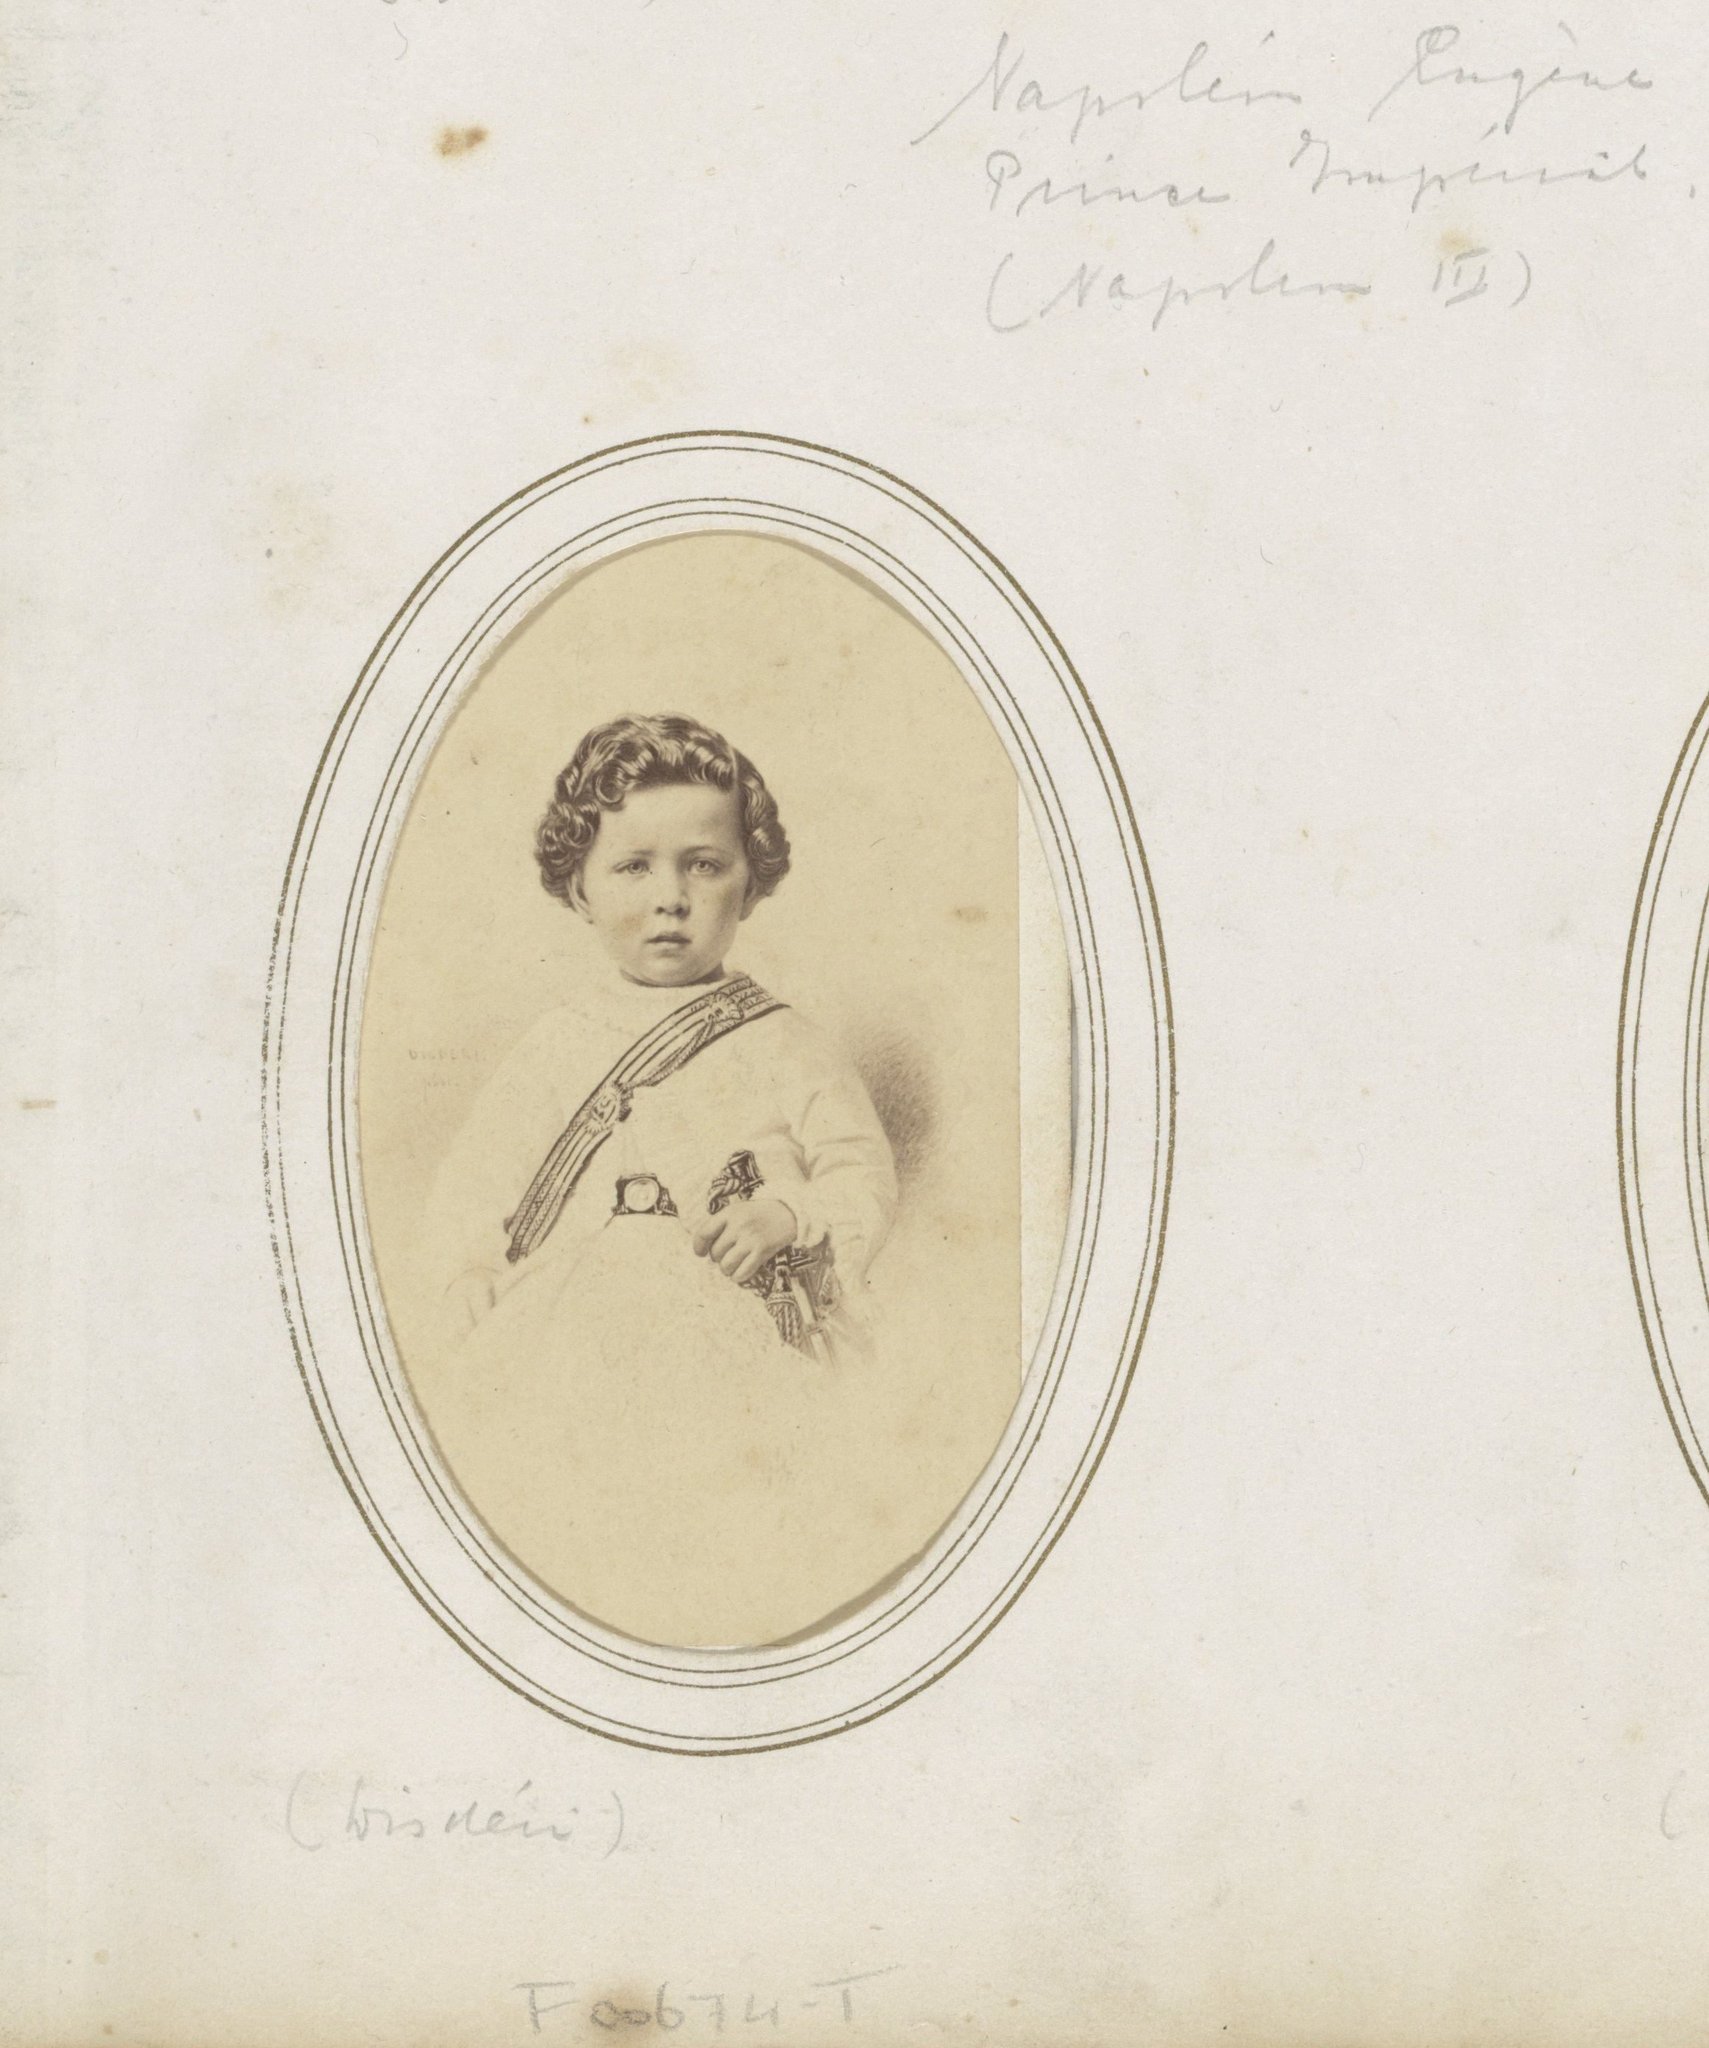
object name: photograph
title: Fotoreproductie van (vermoedelijk) een getekend portret van Napoleon Eugène, kroonprins van Frankrijk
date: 1857-1870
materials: cardboard, paper, photographic support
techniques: albumen print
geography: paris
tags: paris, belt, girdle, waistband, child, historical persons, clothing for the upper part of the body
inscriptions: address: ‘8 Boulevart des Italiens Paris’, inscription: ‘Napoleon Eugene le Prince Imperial de France’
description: Onderdeel van Fotoalbum met 123 cartes-de-visite van leden van Europese vorstenhuizen, politici en bekende personen.